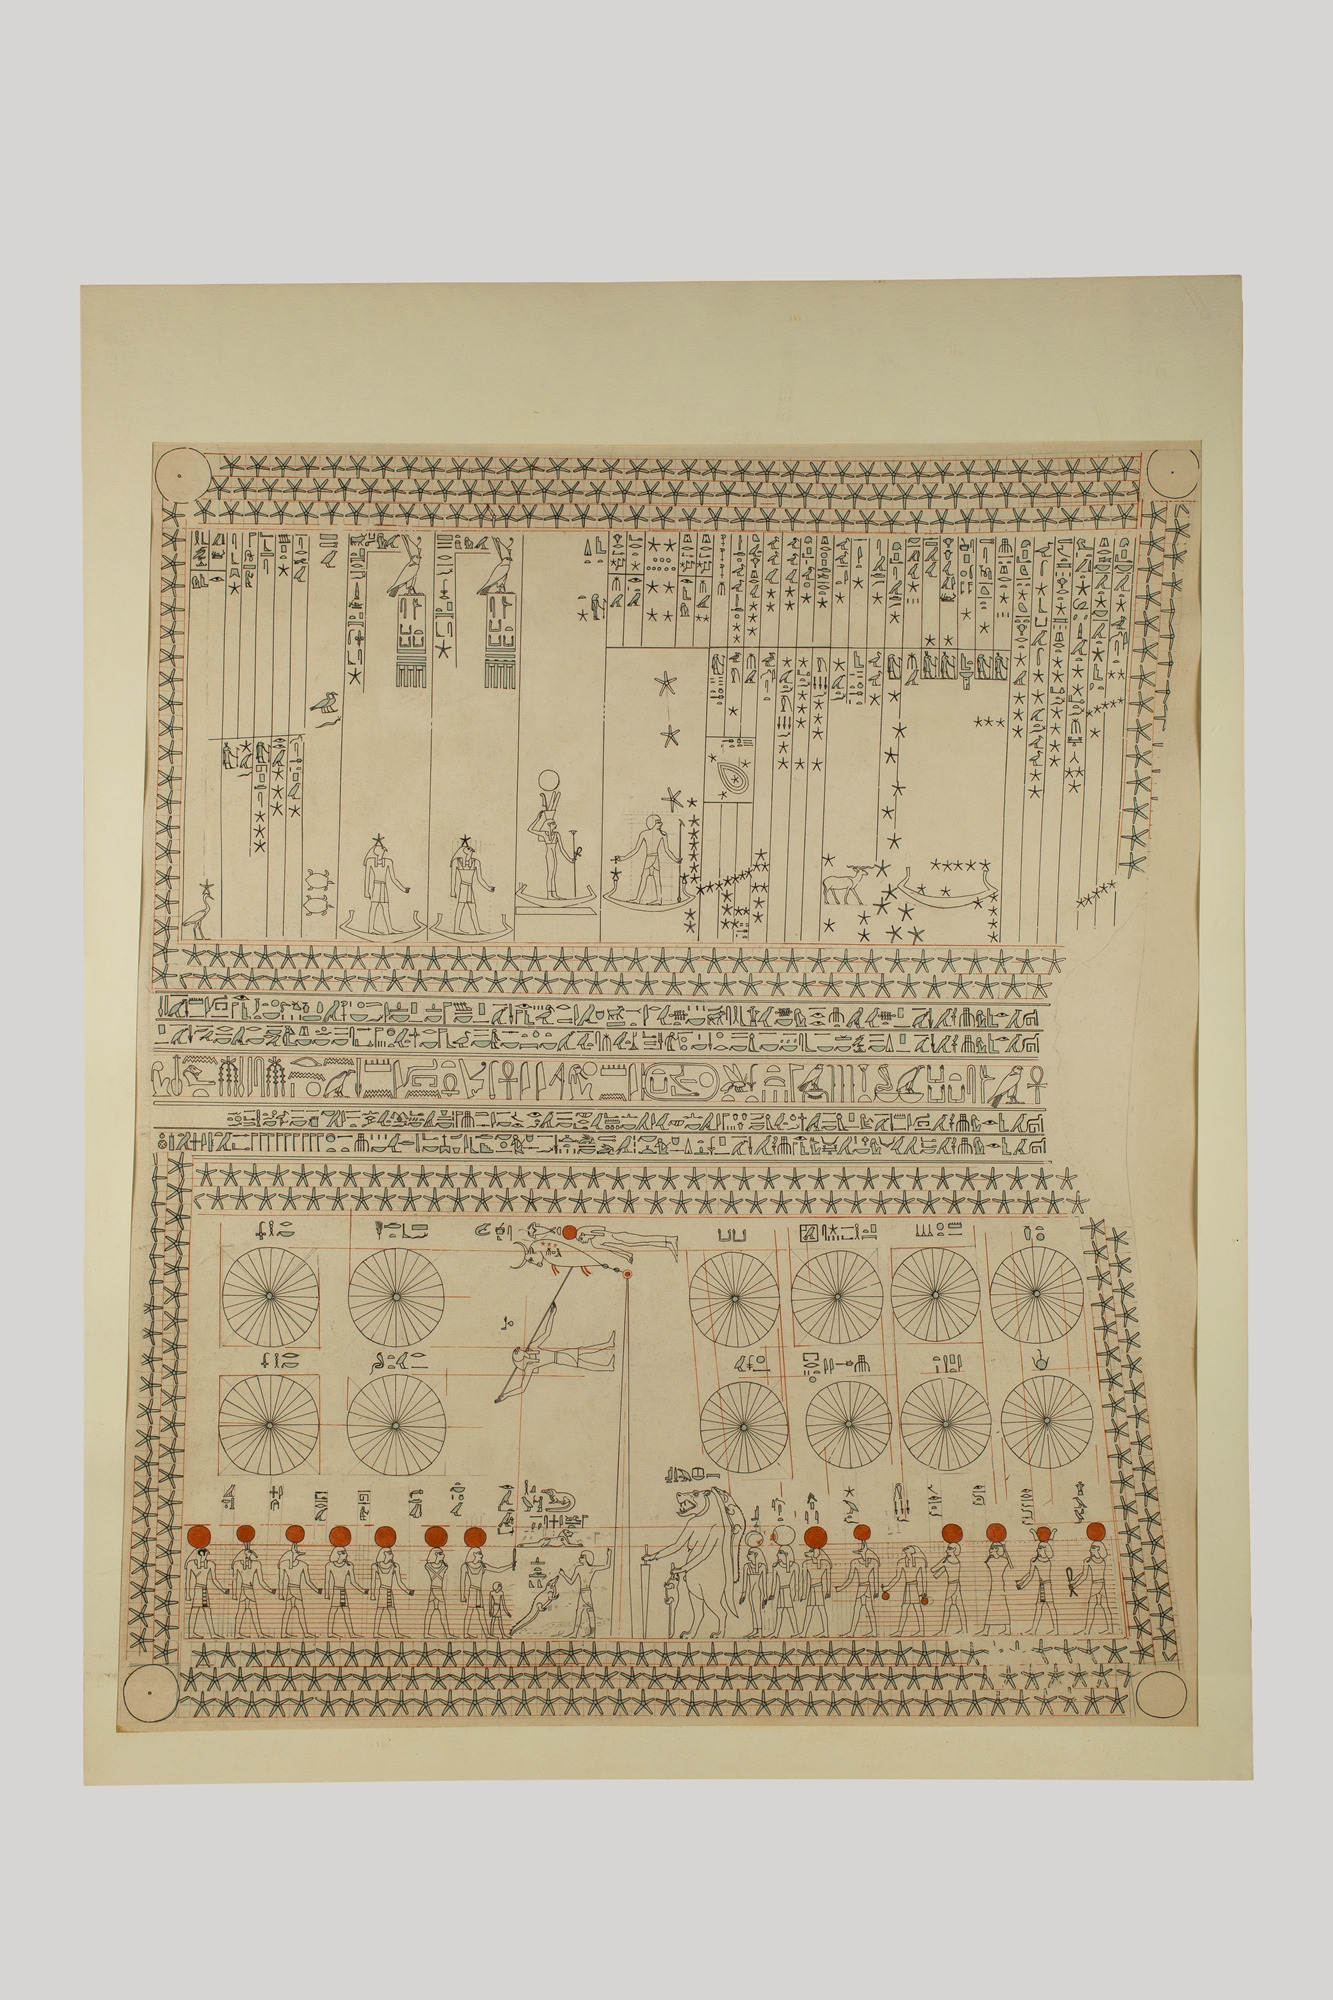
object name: facsimile, senenmut tt 353, astronomical ceiling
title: Astronomical Ceiling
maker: charles k. wilkinson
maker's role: artist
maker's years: 1897-1986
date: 1479-1458 BCE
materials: paper, paint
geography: egypt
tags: hieroglyphs,astronomy